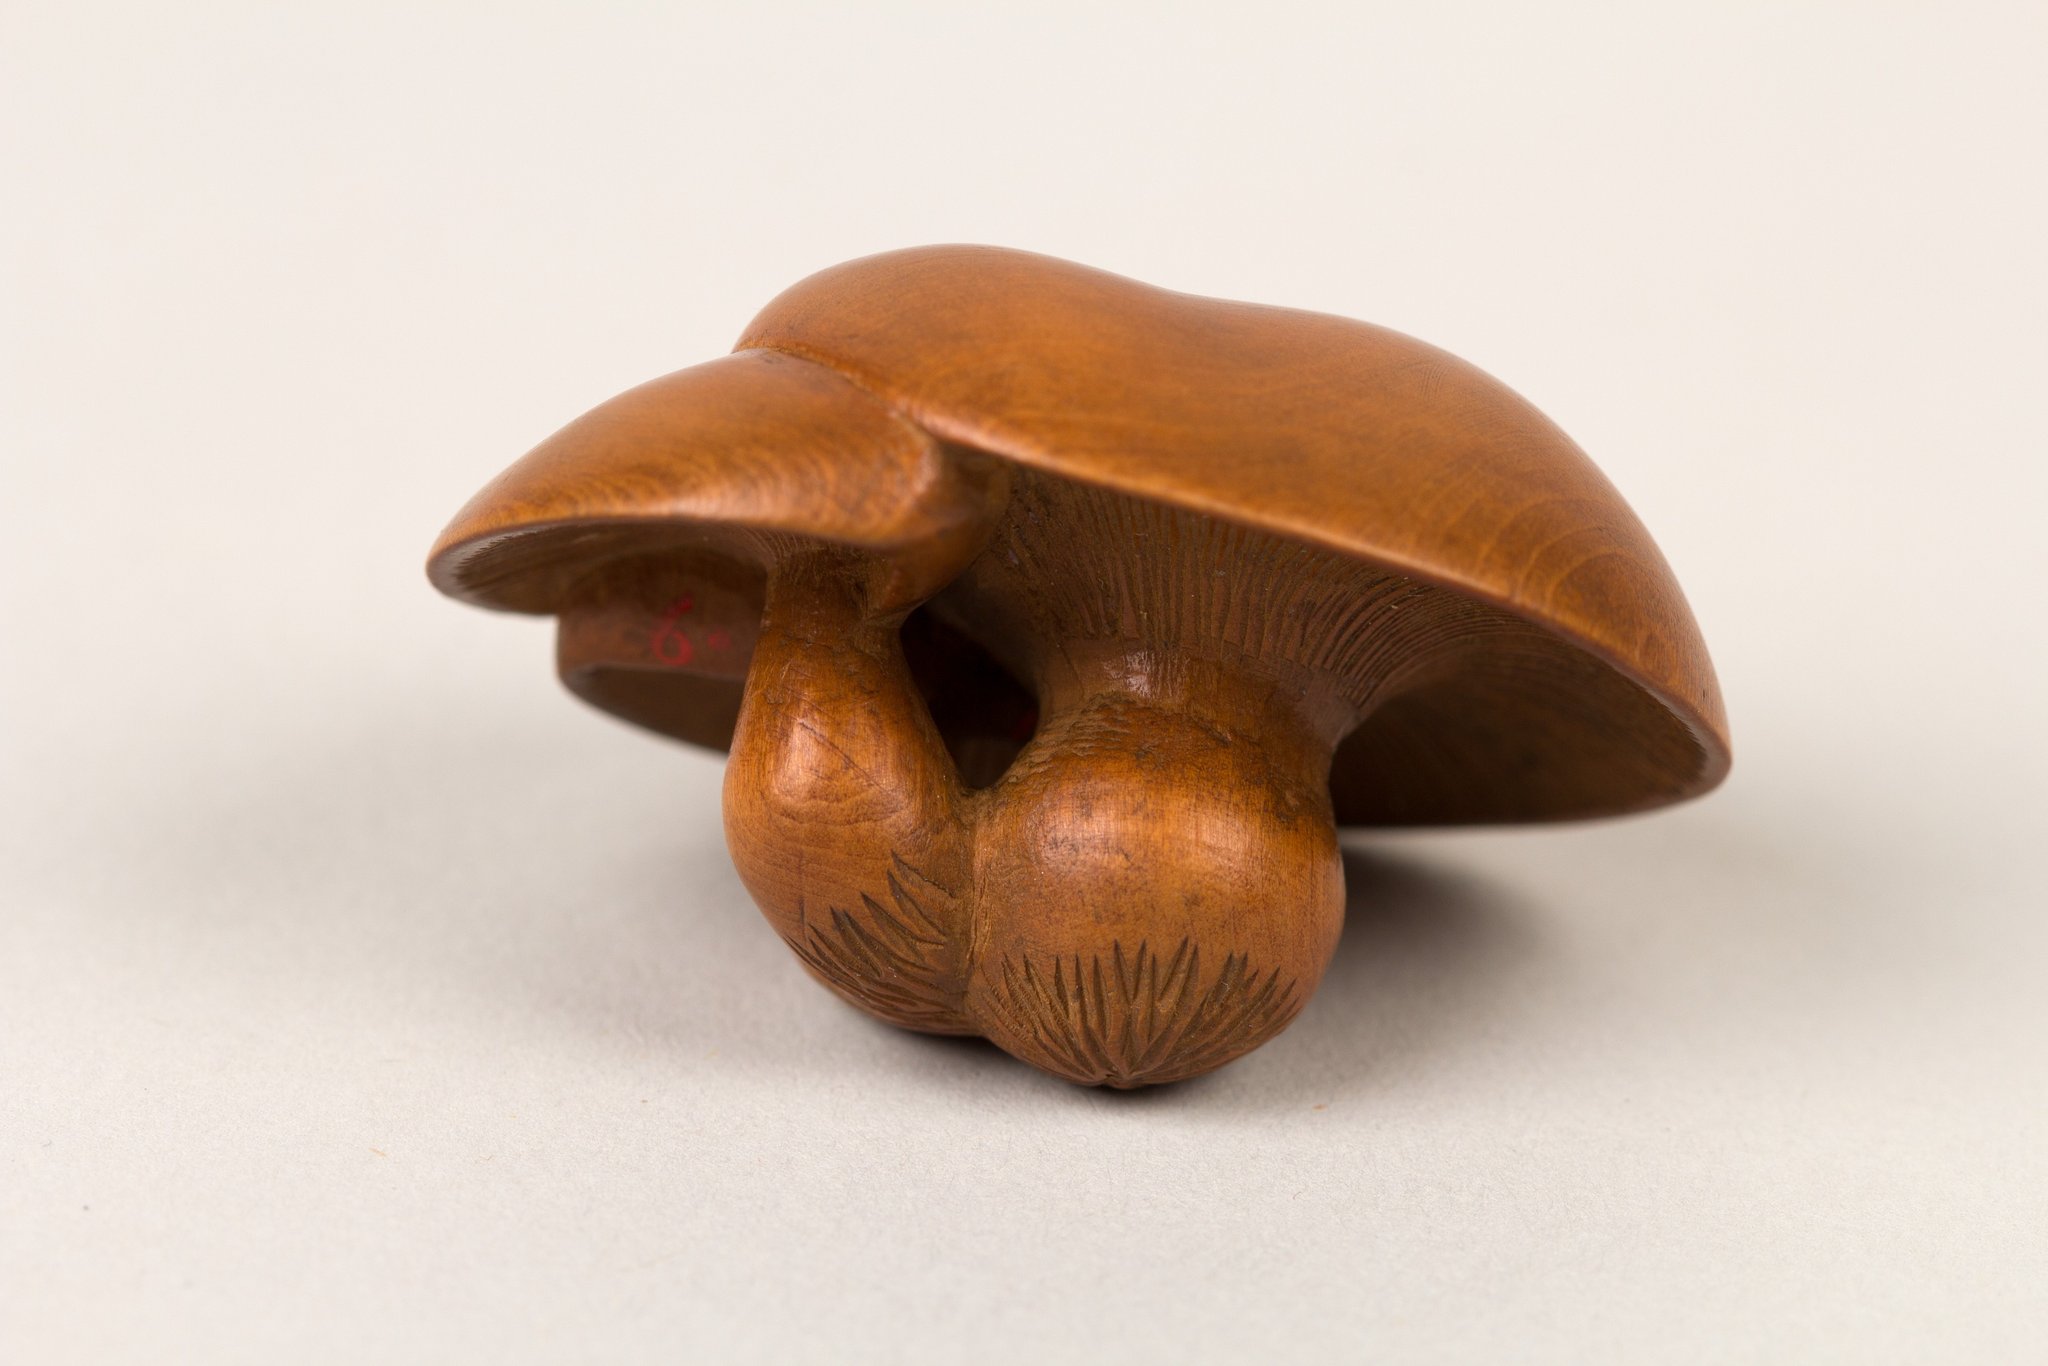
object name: netsuke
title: Netsuke of Three Mushrooms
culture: japanese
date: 1867-1900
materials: wood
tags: vegetables